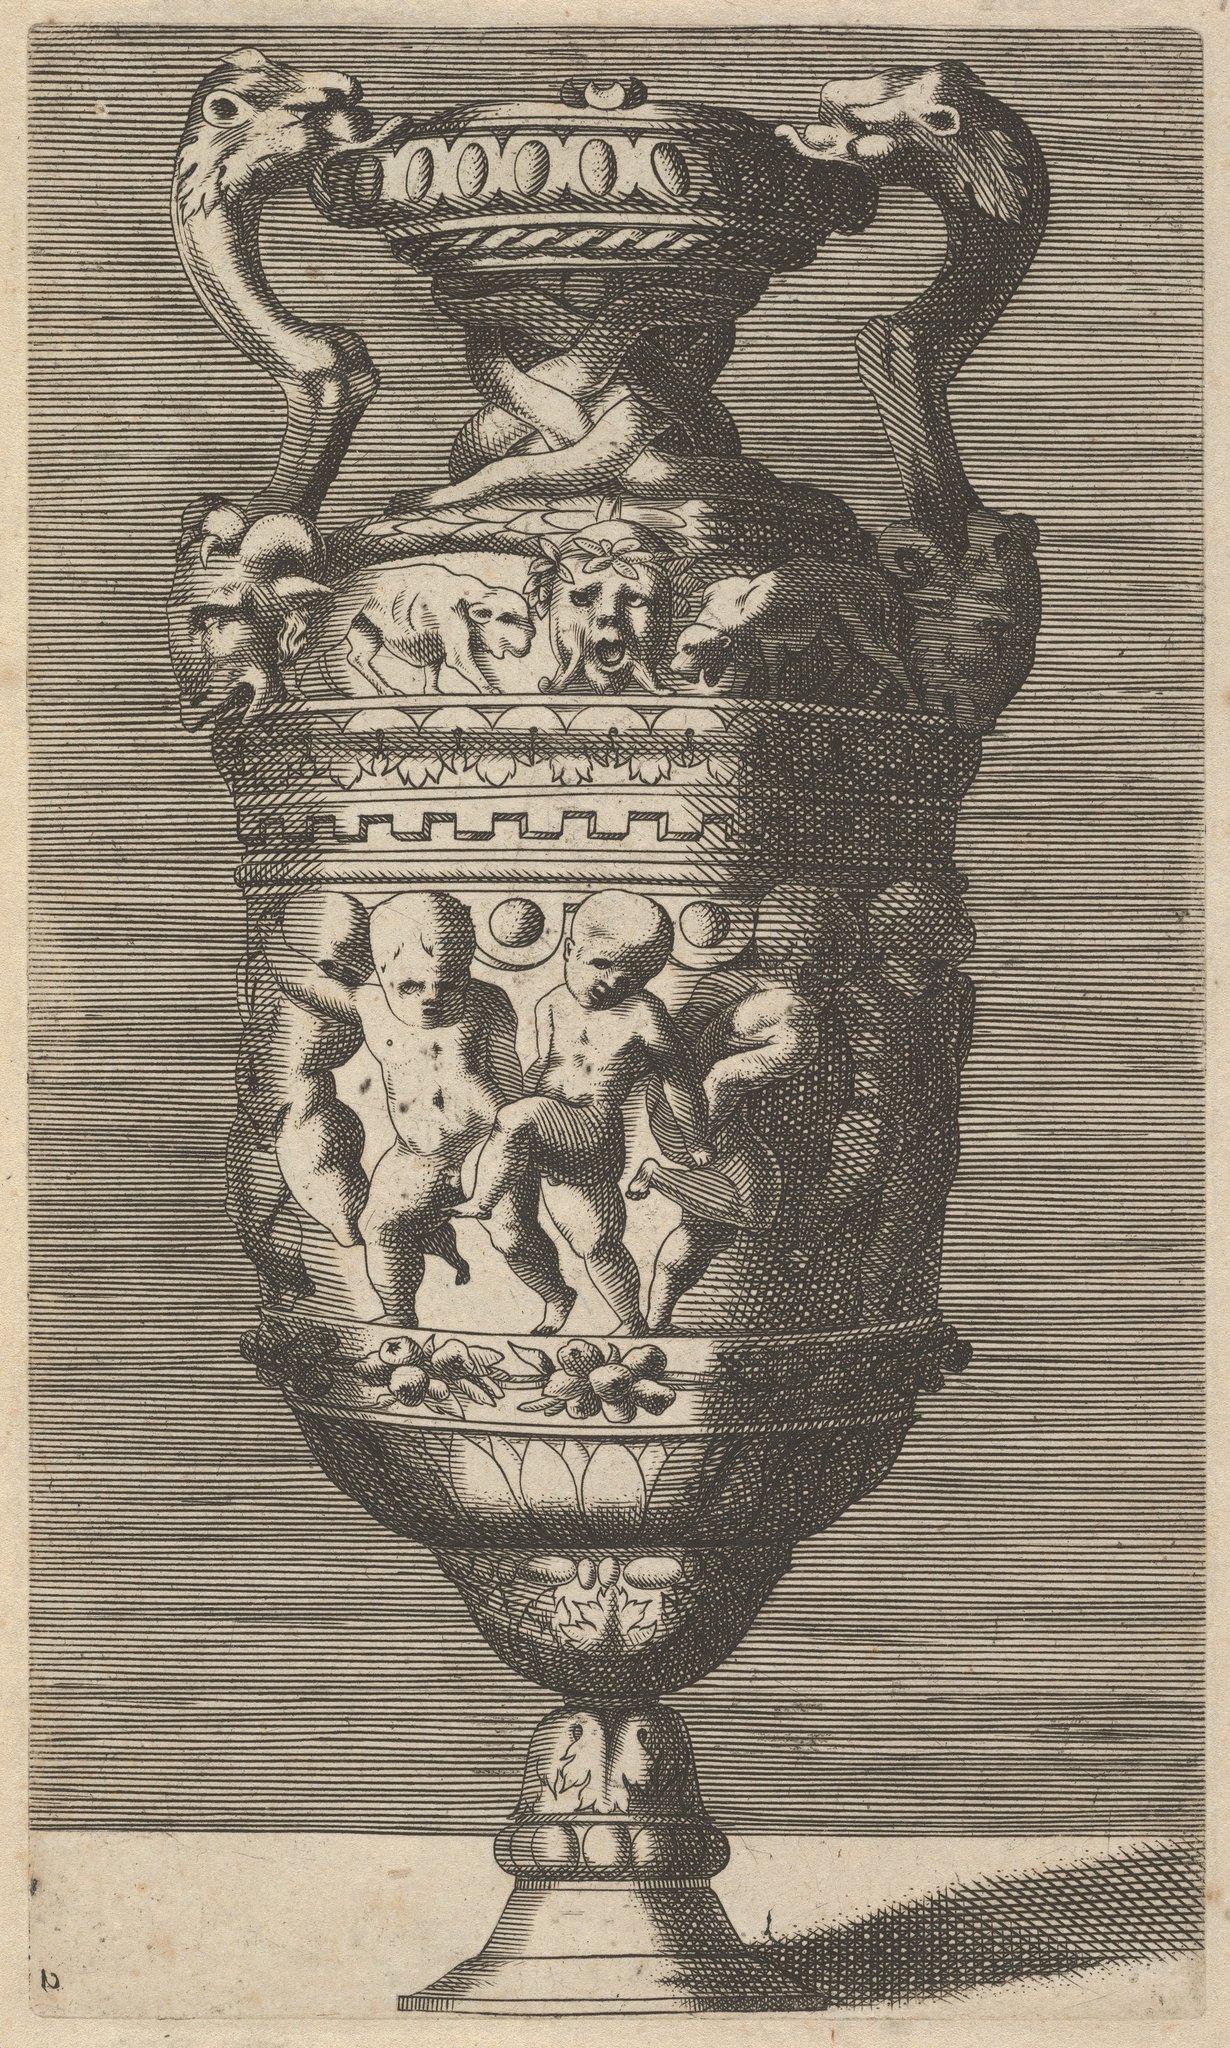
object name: print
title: Vase with Dancing Putti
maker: rené boyvin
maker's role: artist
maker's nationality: french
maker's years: 1525-1598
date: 1601-1700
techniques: engraving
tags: dancing,putti,vases